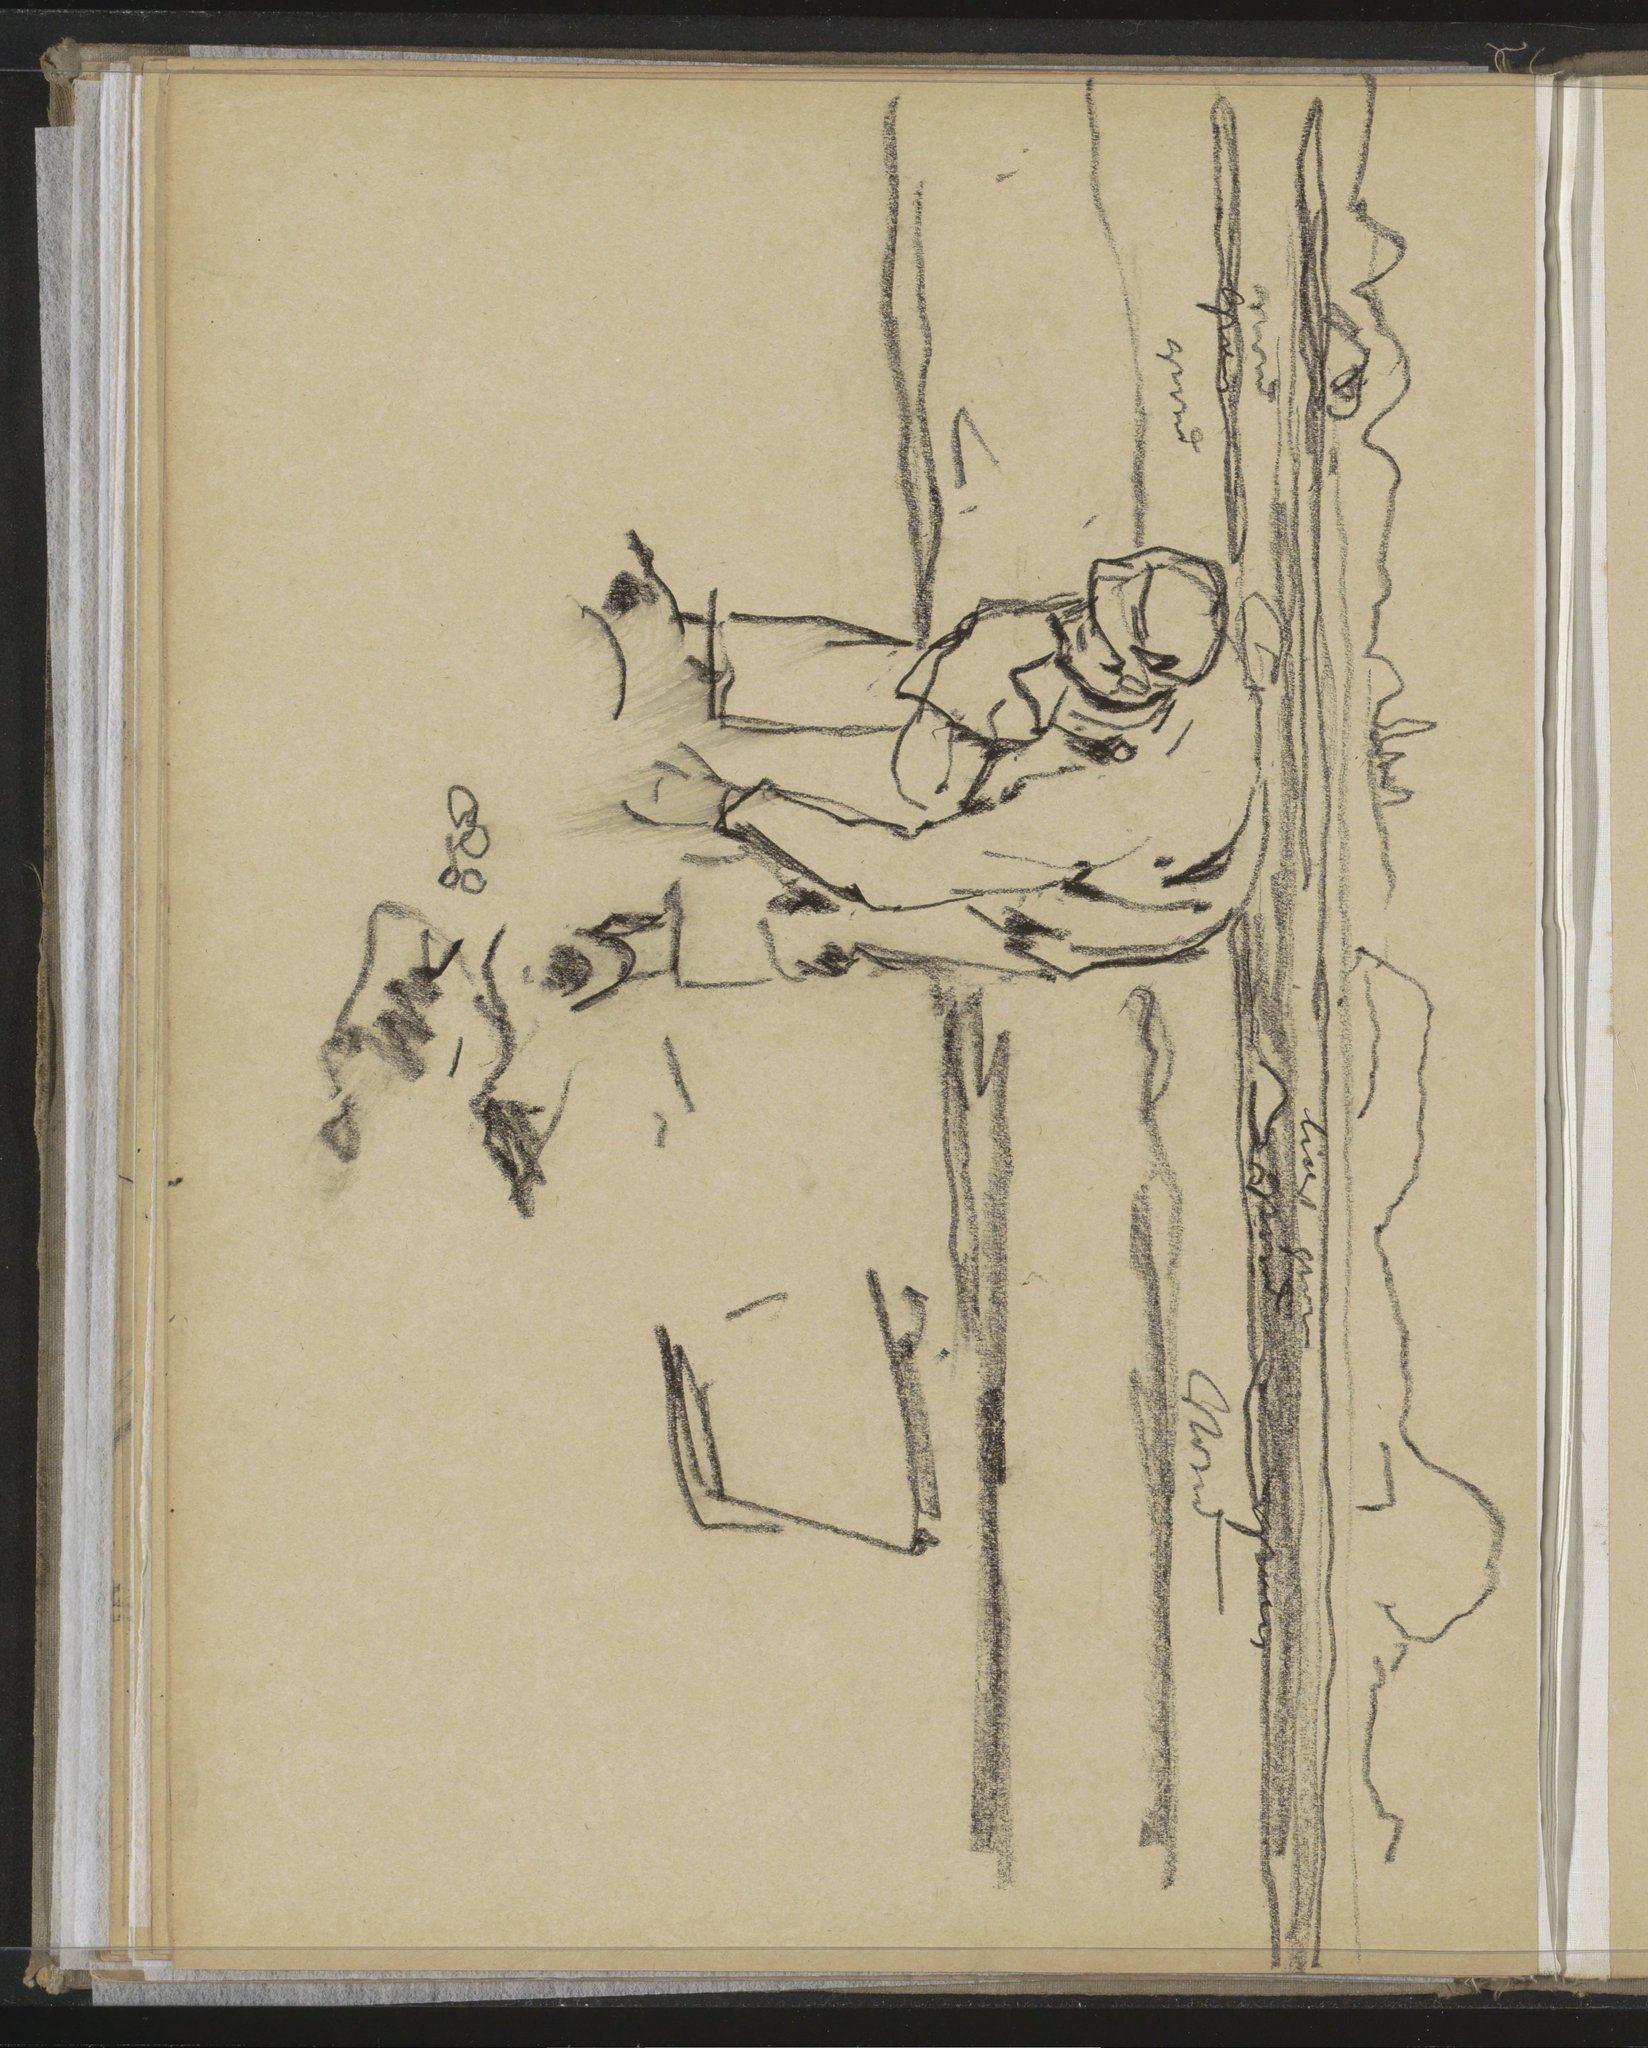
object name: sketchbook leaf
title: Boer aan het werk op het land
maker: willem witsen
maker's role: draughtsman, painter, print maker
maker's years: 1860-1923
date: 1893-1897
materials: chalk, paper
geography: ede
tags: farmers, cultivated land (+ landscape with figures, staffage)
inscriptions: kleurnotitie, handgeschreven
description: Pagina 38 uit een schetsboek met 25 bladen.